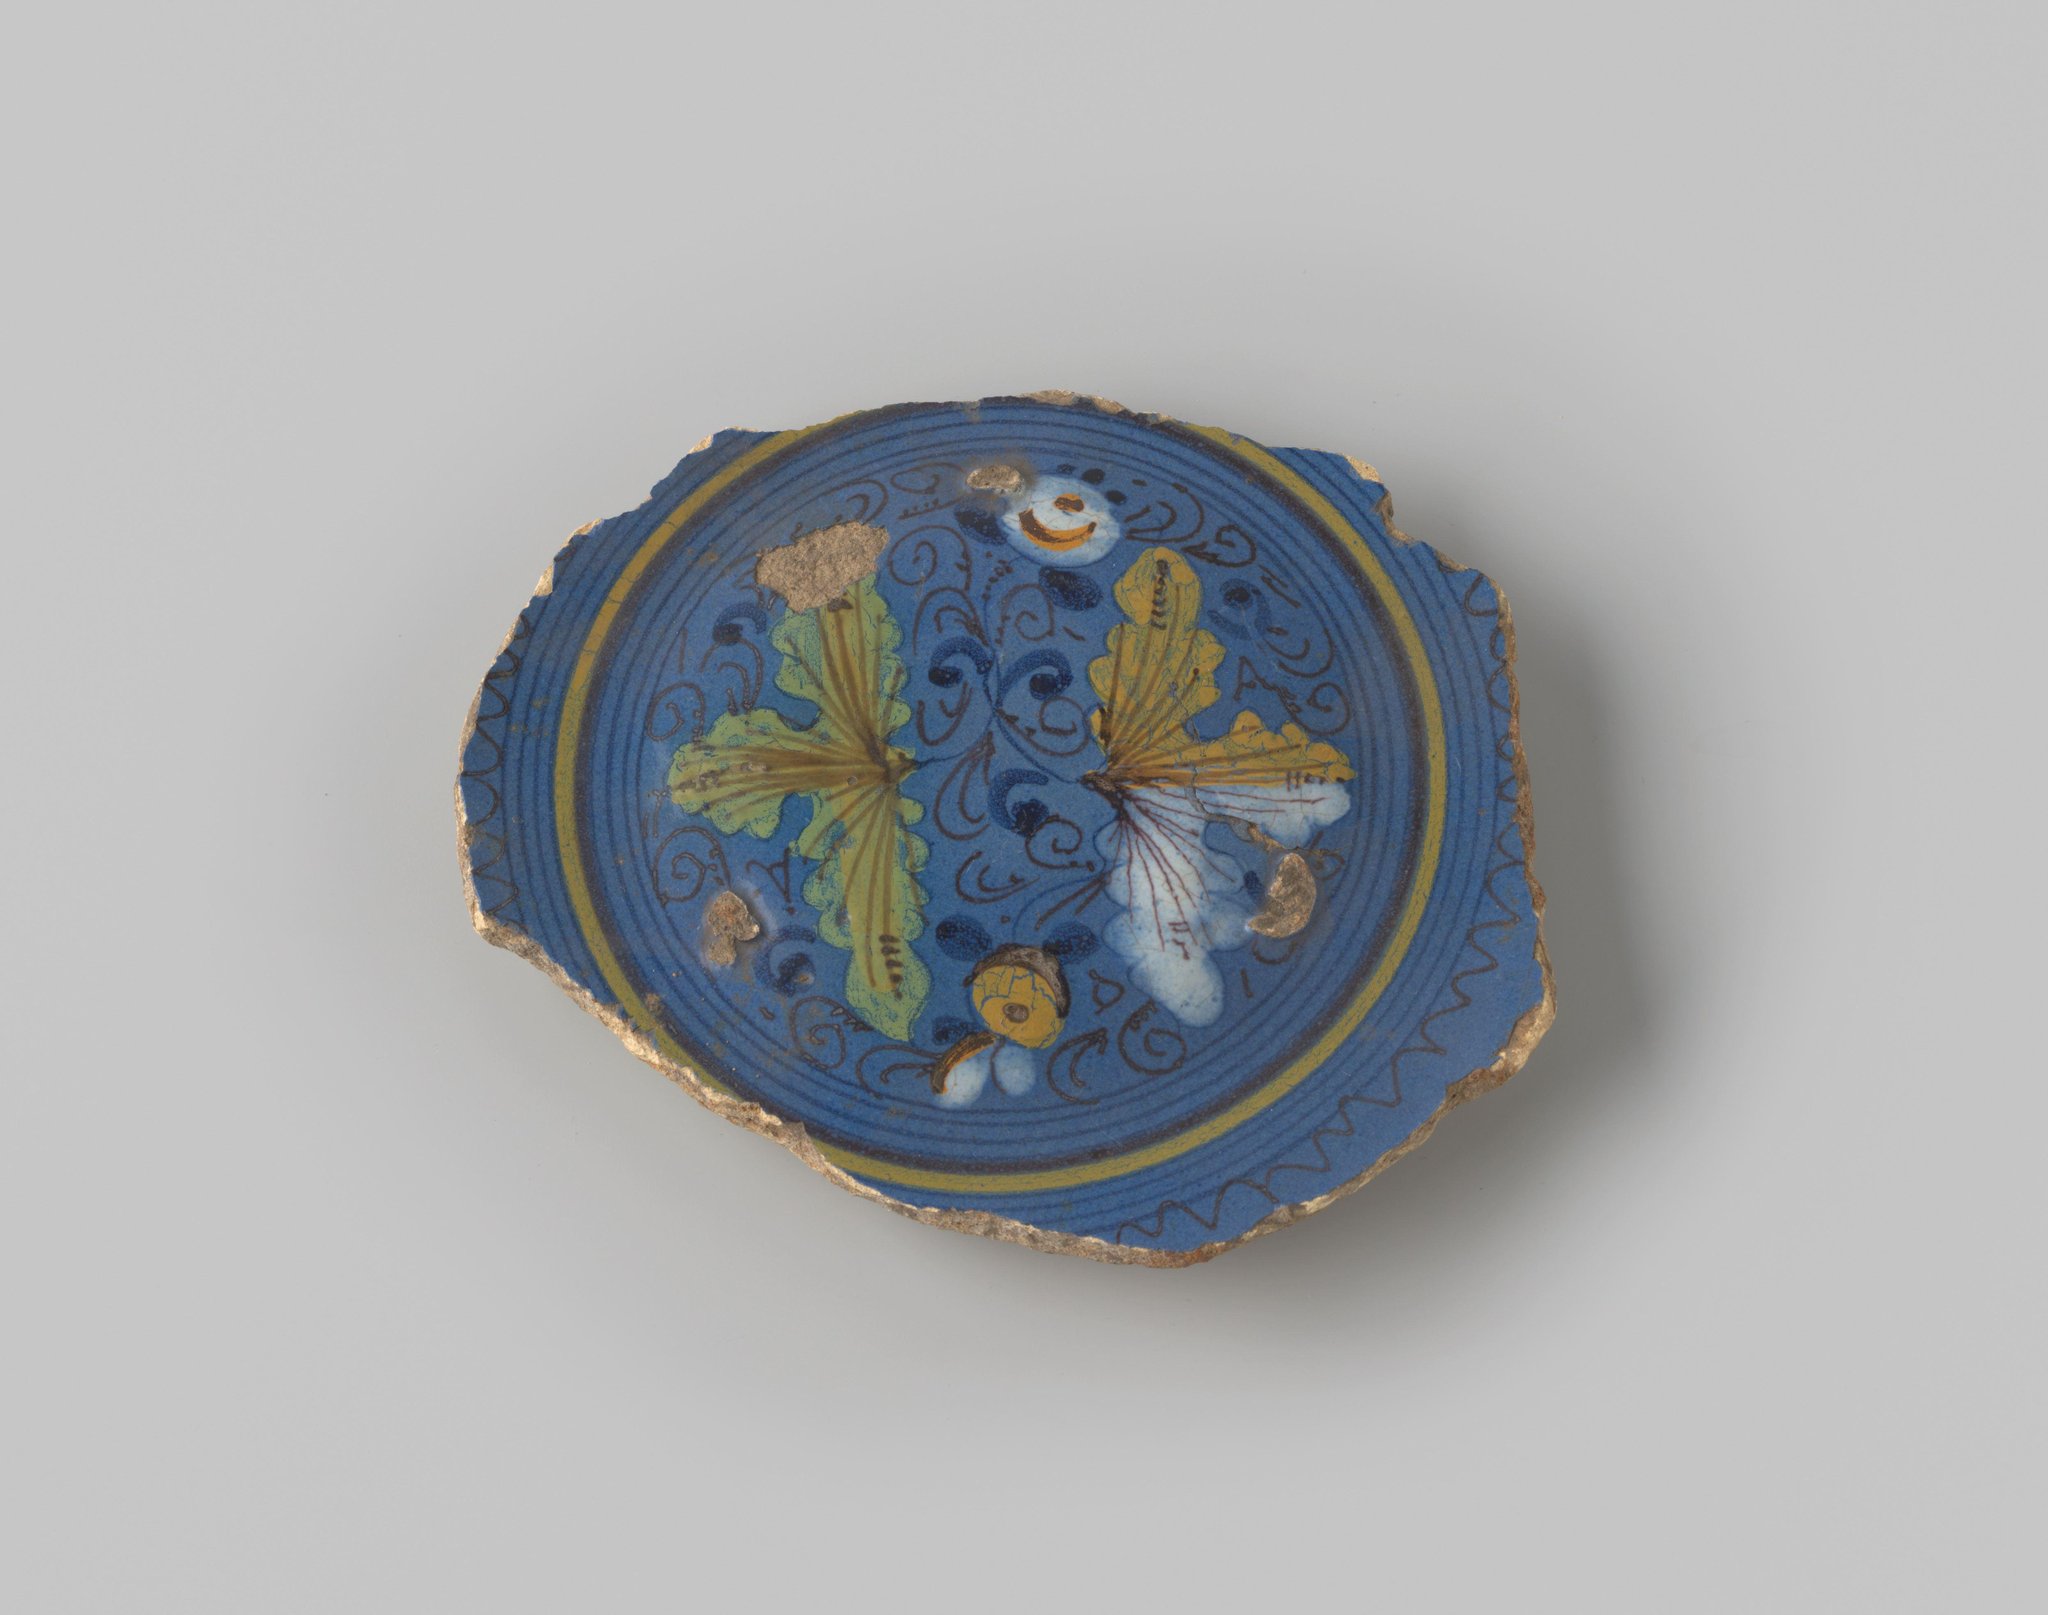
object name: sherd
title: Scherf van geligbakkend aardewerk, met voetring, aan de voorzijde voorzien van blauw glazuur, met op het plat een schildering met bladeren en bloemen in bruin, blauw, groen, oranje, geel en wit, en daar omheen cirkels en een gegolfde rand in bruin en geel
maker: Anonymous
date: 1600-1650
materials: earthenware, glaze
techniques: maiolica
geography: northern netherlands